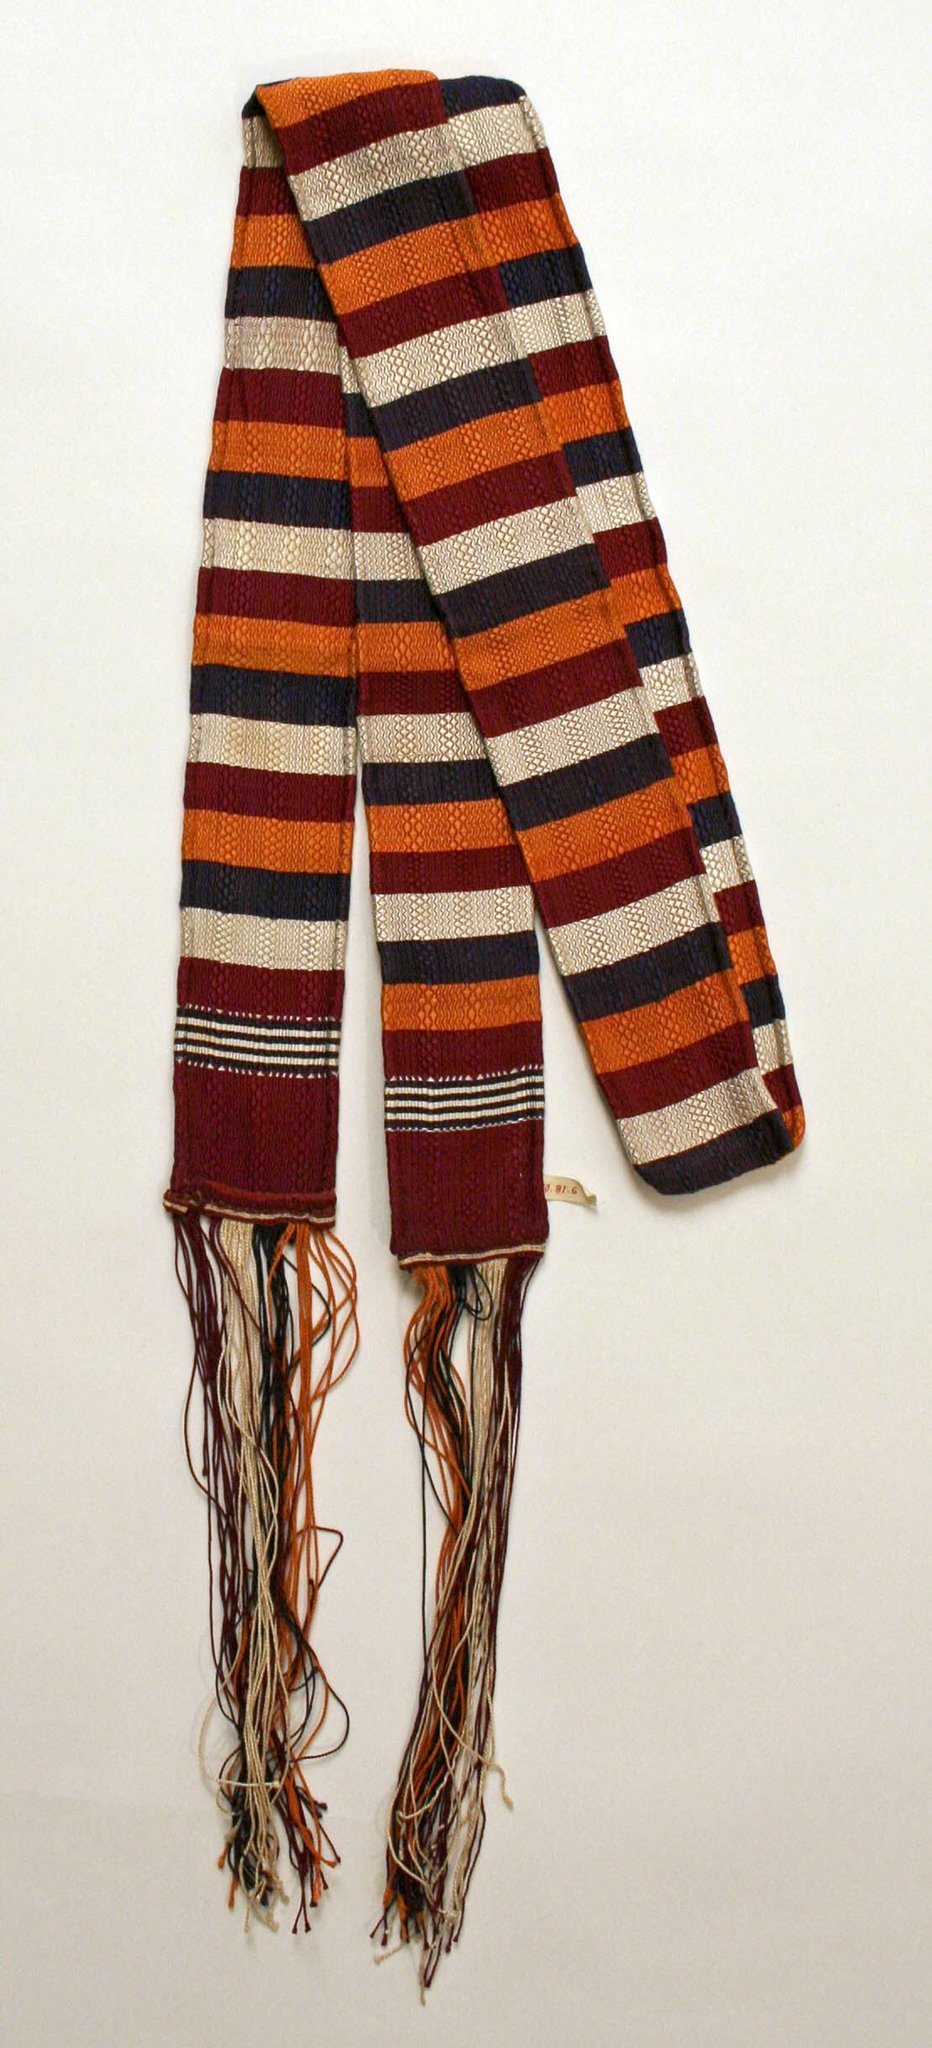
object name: girdle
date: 1882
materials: silk